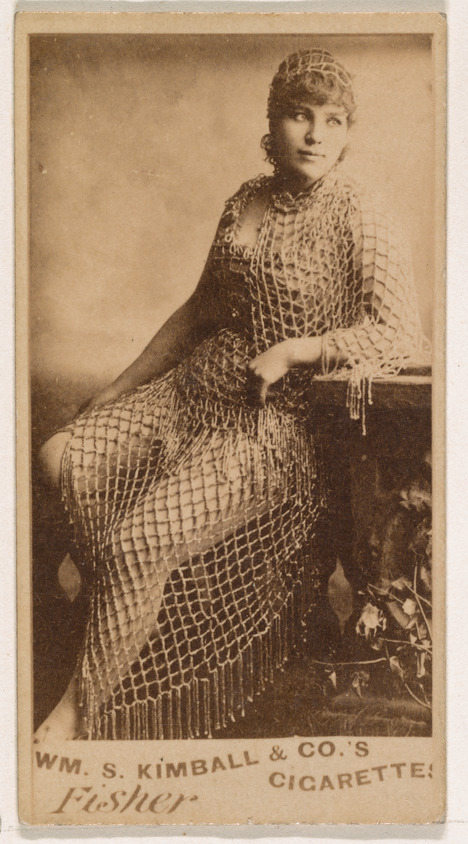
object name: photograph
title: Miss Fisher, from the Actresses series (N203) issued by Wm. S. Kimball & Co.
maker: william s. kimball & company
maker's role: publisher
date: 1889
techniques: color lithograph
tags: portraits,women,actresses